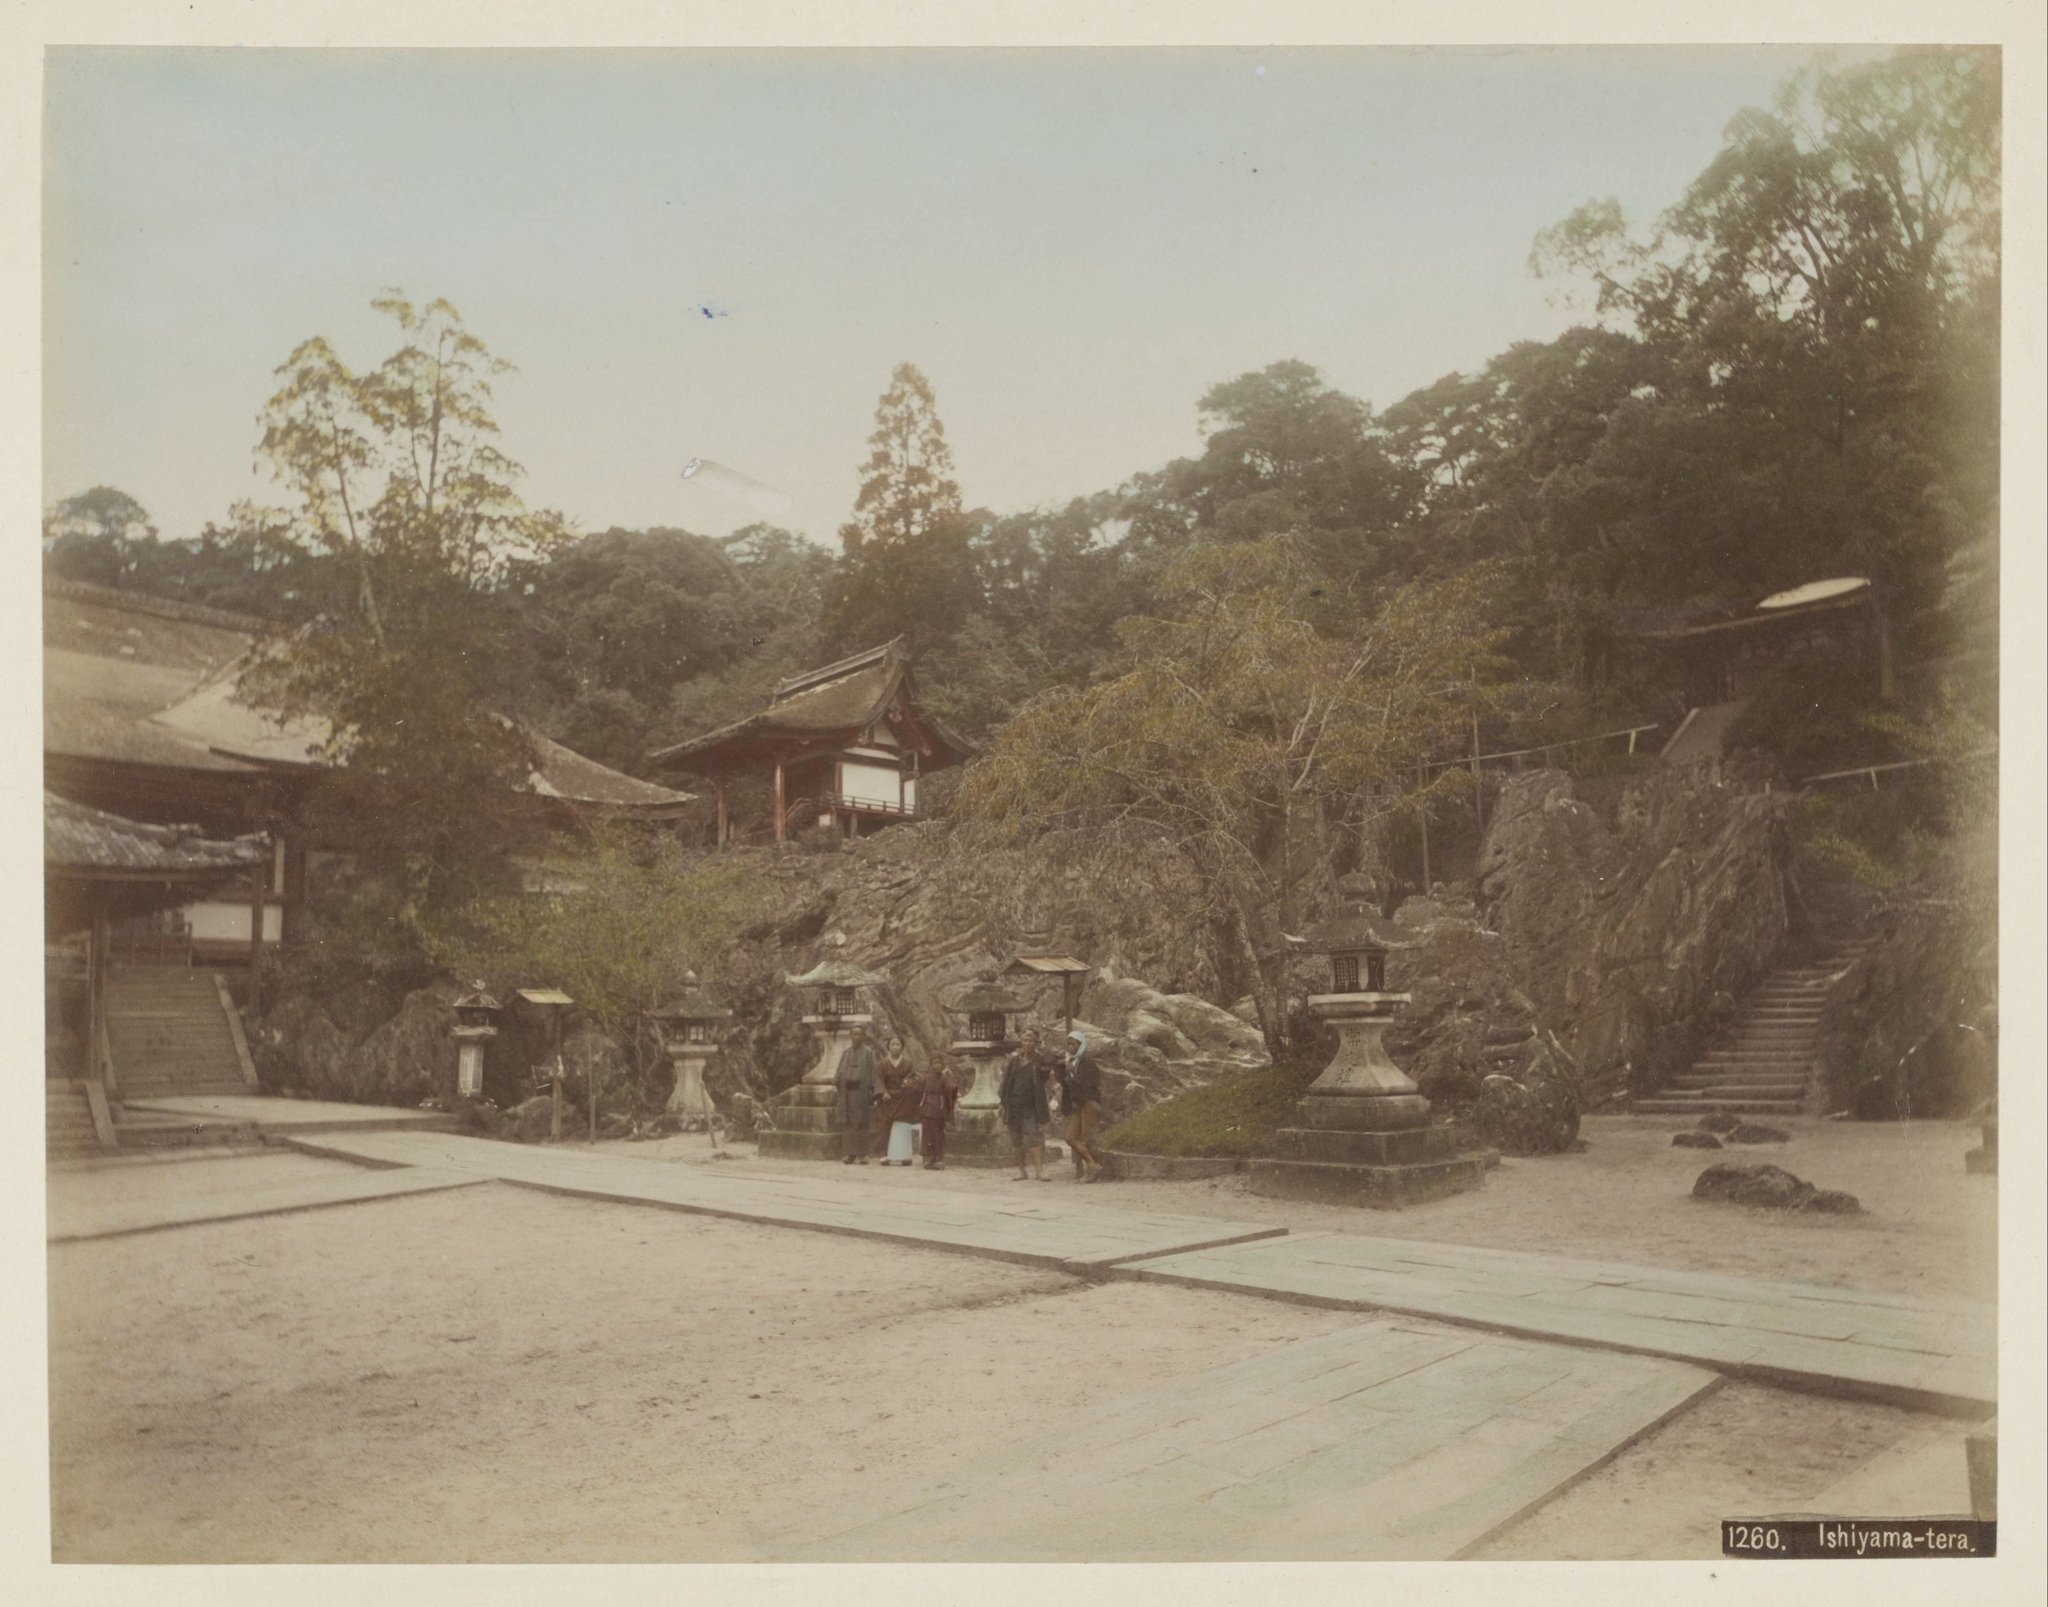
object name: photograph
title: Gezicht op de Ishiyama-tempel met op de voorgrond plankieren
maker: Anonymous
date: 1870-1900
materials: paper, photographic support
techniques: albumen print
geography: otsu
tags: temple, shrine ~ hinduism, buddhism, jainism, floor-covering, travelling; tourism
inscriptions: negative number: ‘1260’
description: Onderdeel van Fotoalbum met 50 foto's van bezienswaardigheden in Japan.